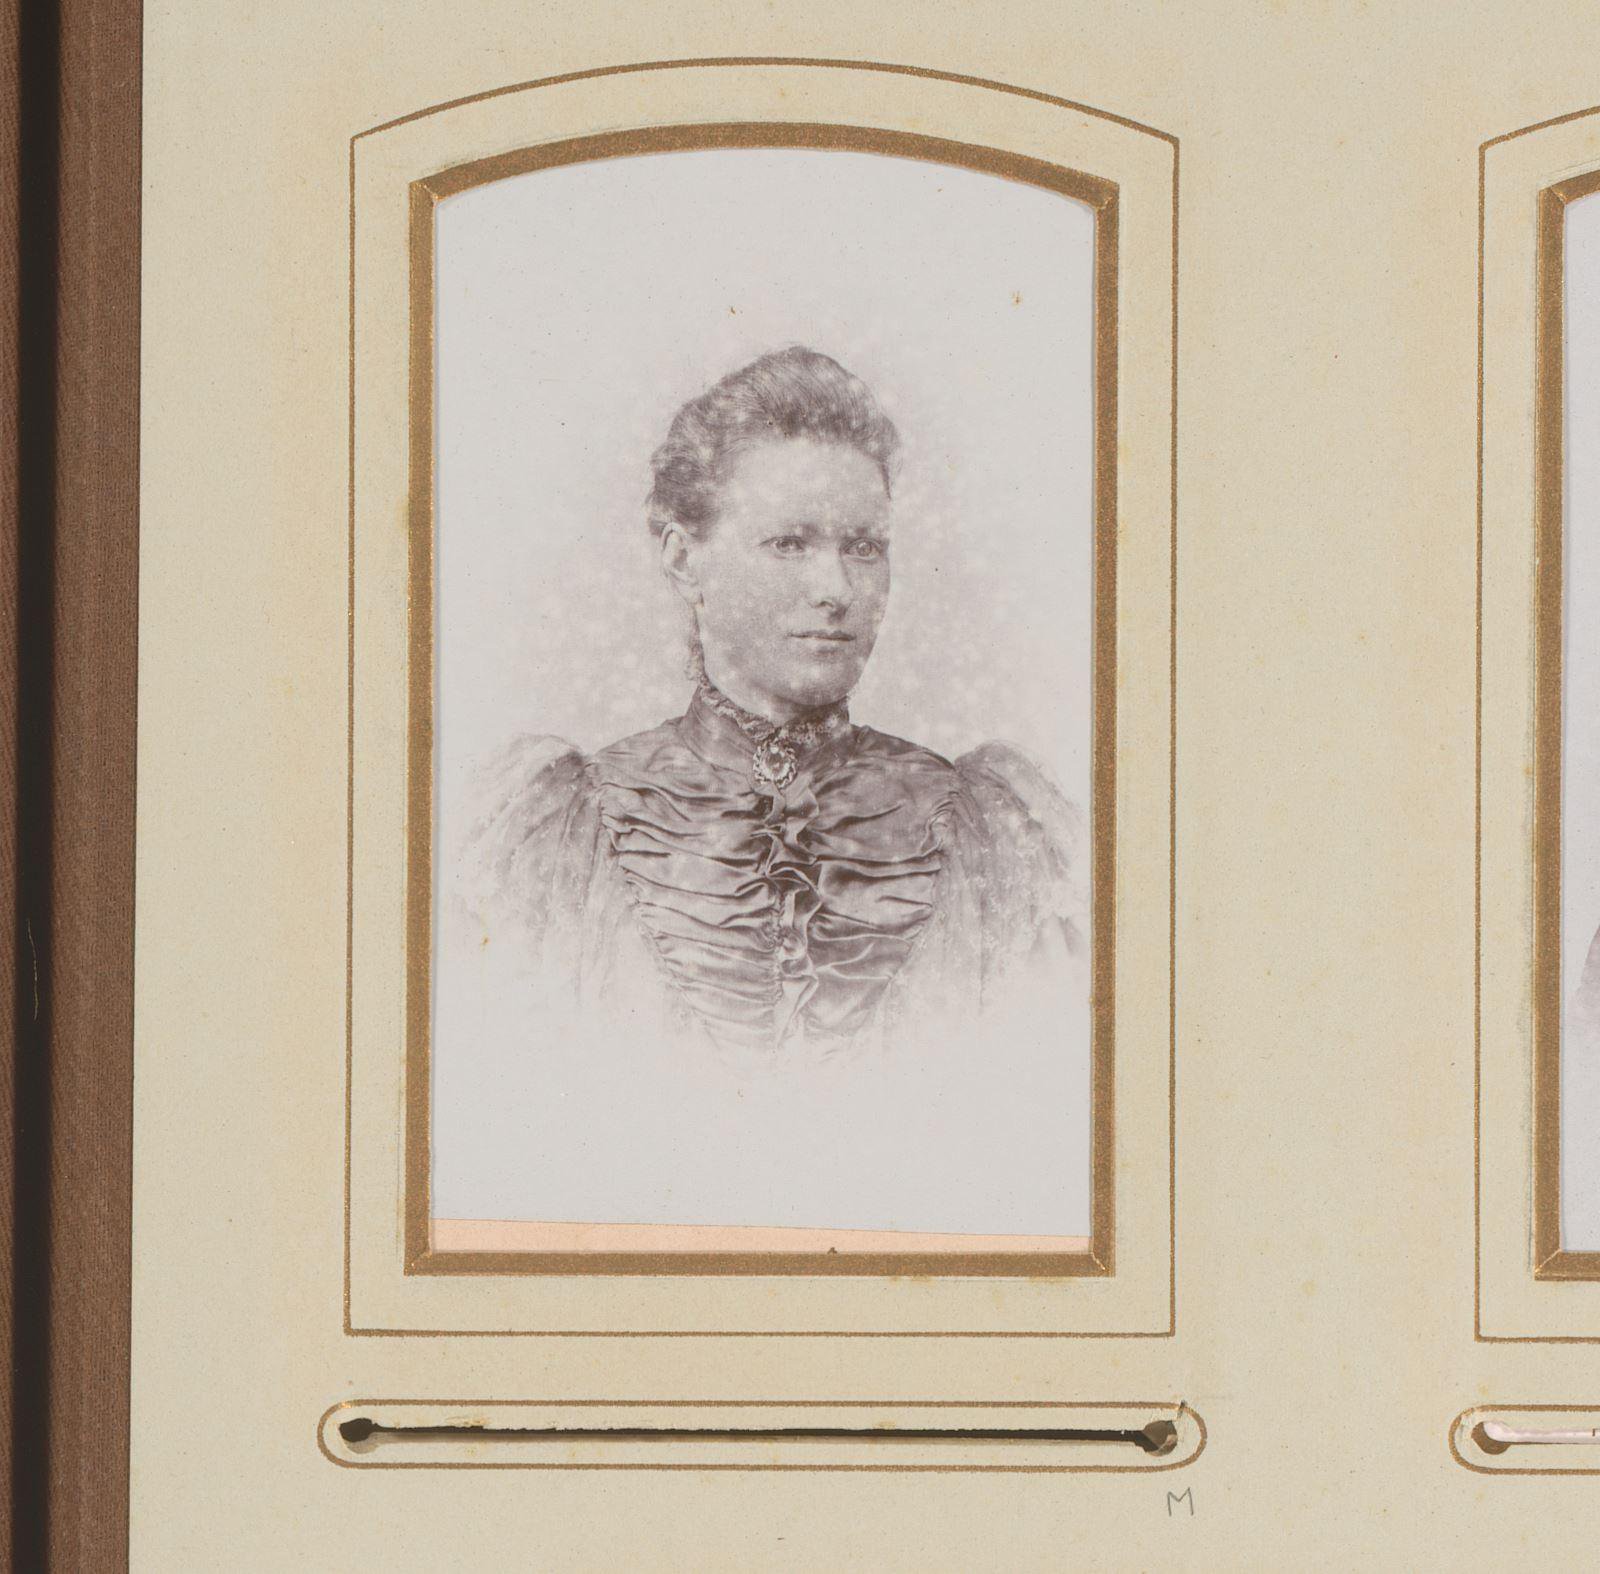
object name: album leaf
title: Portret van een vrouw in hooggesloten jurk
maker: friedrich julius von kolkow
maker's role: fotograaf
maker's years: 1839-1914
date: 1880-1913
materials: cardboard, photographic support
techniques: collodion silver print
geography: groningen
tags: historical persons - bb - woman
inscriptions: inscription: ‘(...)/ Fr. Jul von Kolkow/ Koninklyk Nederlandsch Hof-Photograph/ (...)/ GRONINGEN/ Groote Markt by de/ Martinitoorn./ Specialiteit in Vergrootingen.’